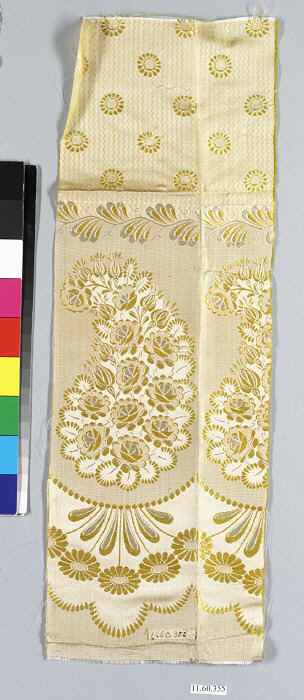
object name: fragment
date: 1801-1900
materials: silk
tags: flowers,leaves